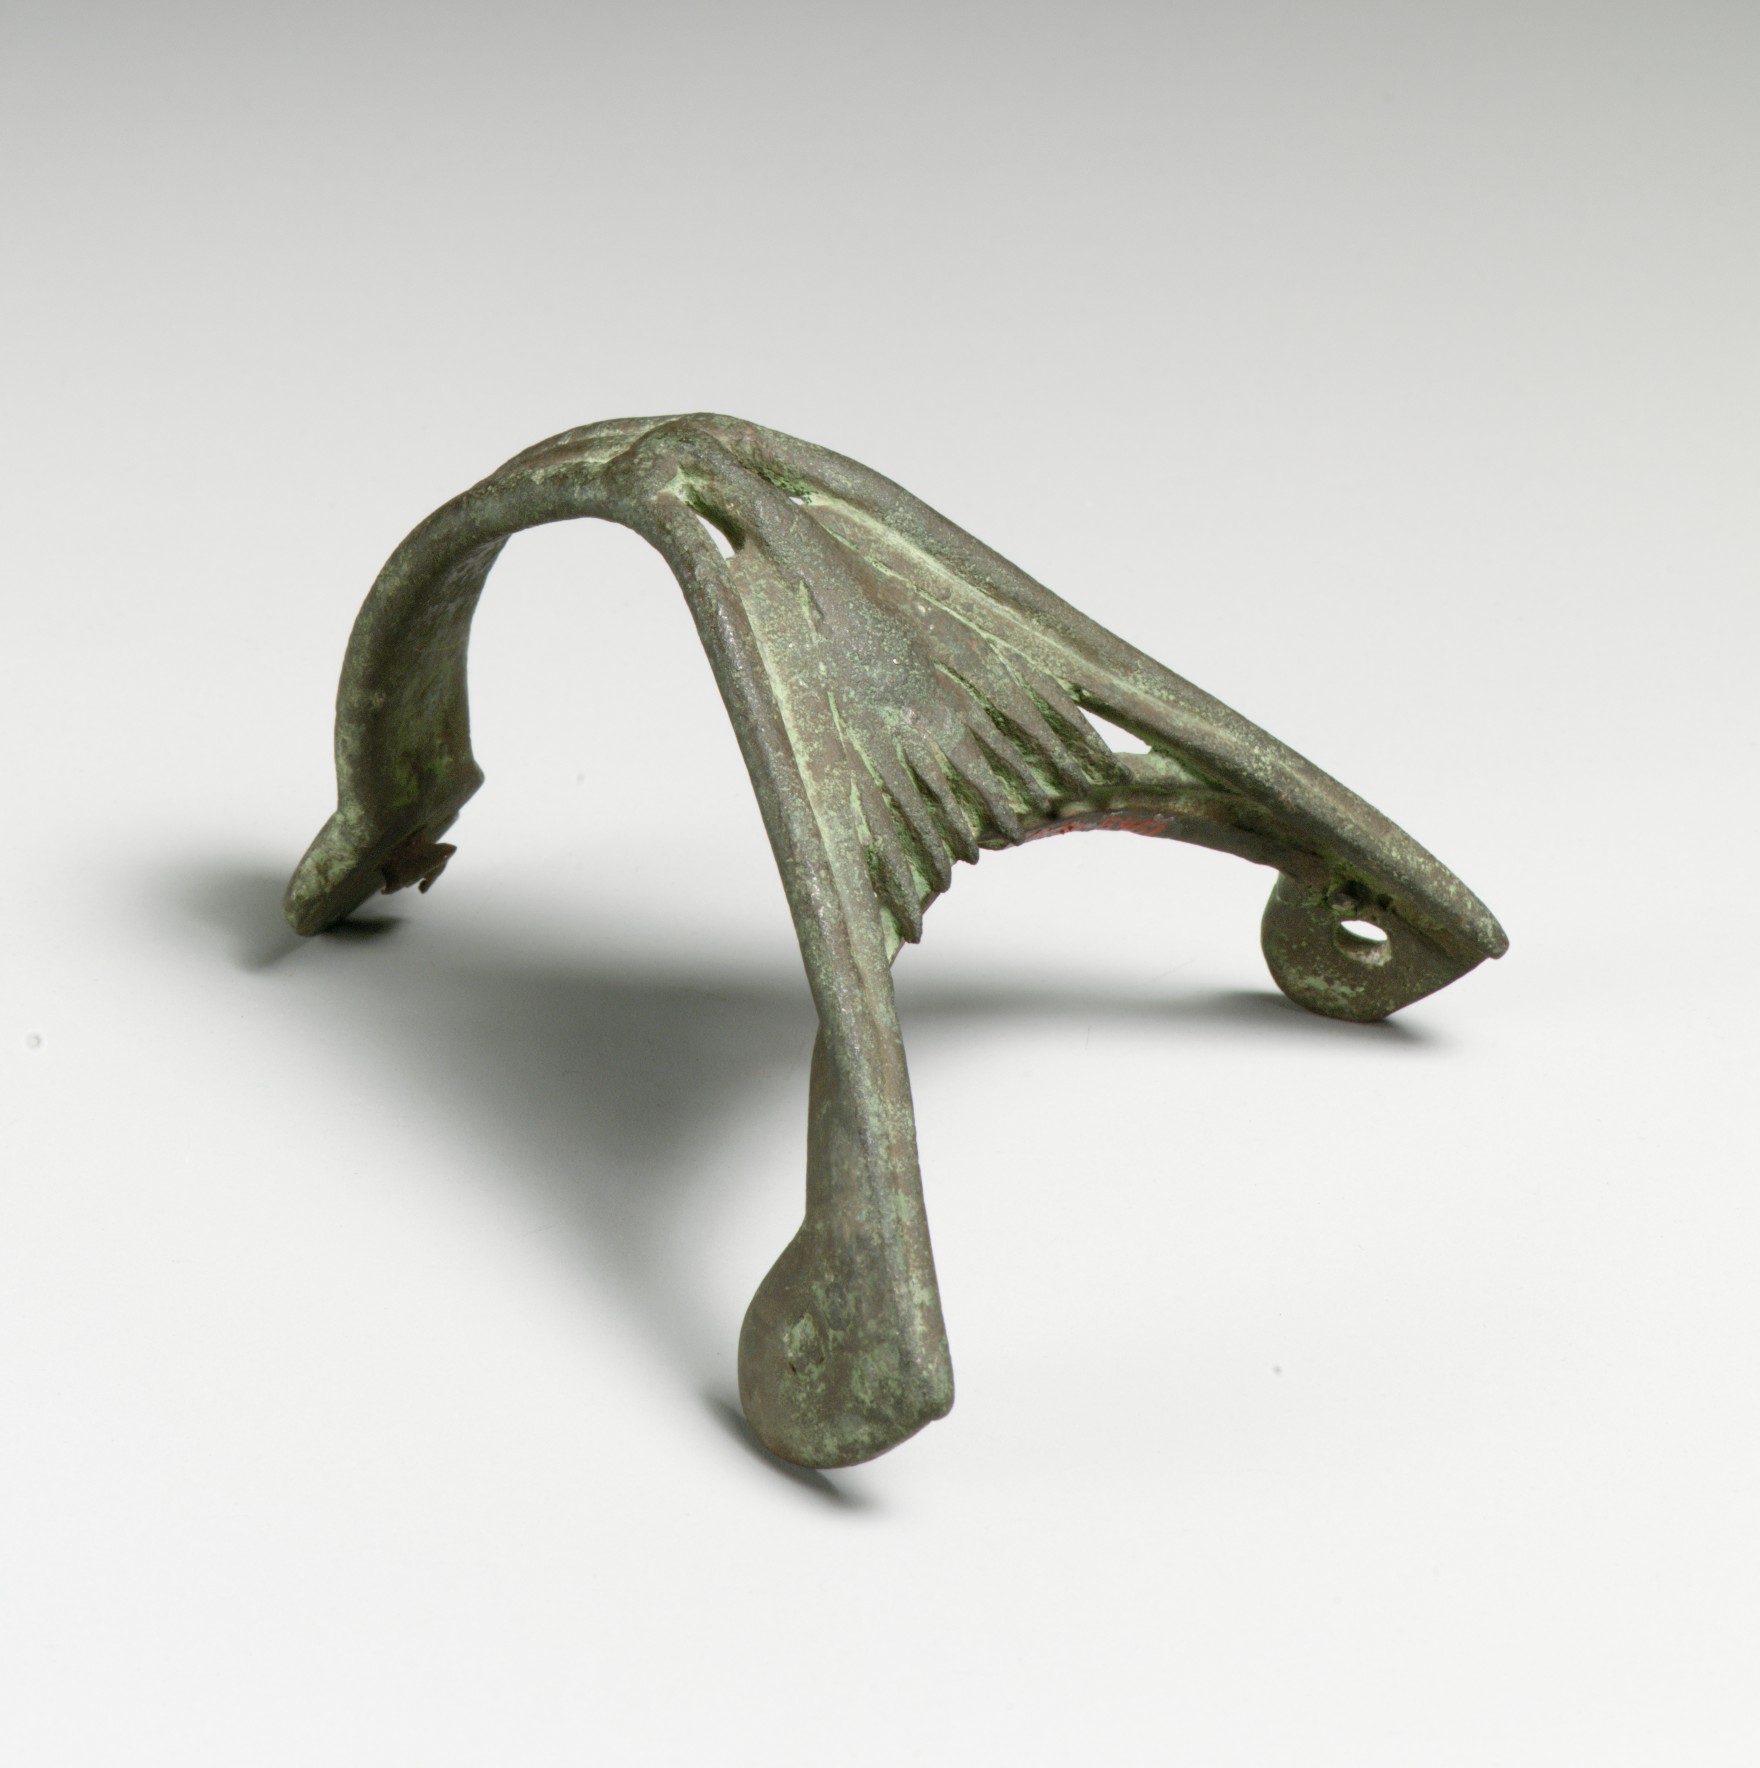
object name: handle of a jug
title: Bronze handle of a jug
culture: egyptian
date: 1550-1185 BCE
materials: bronze